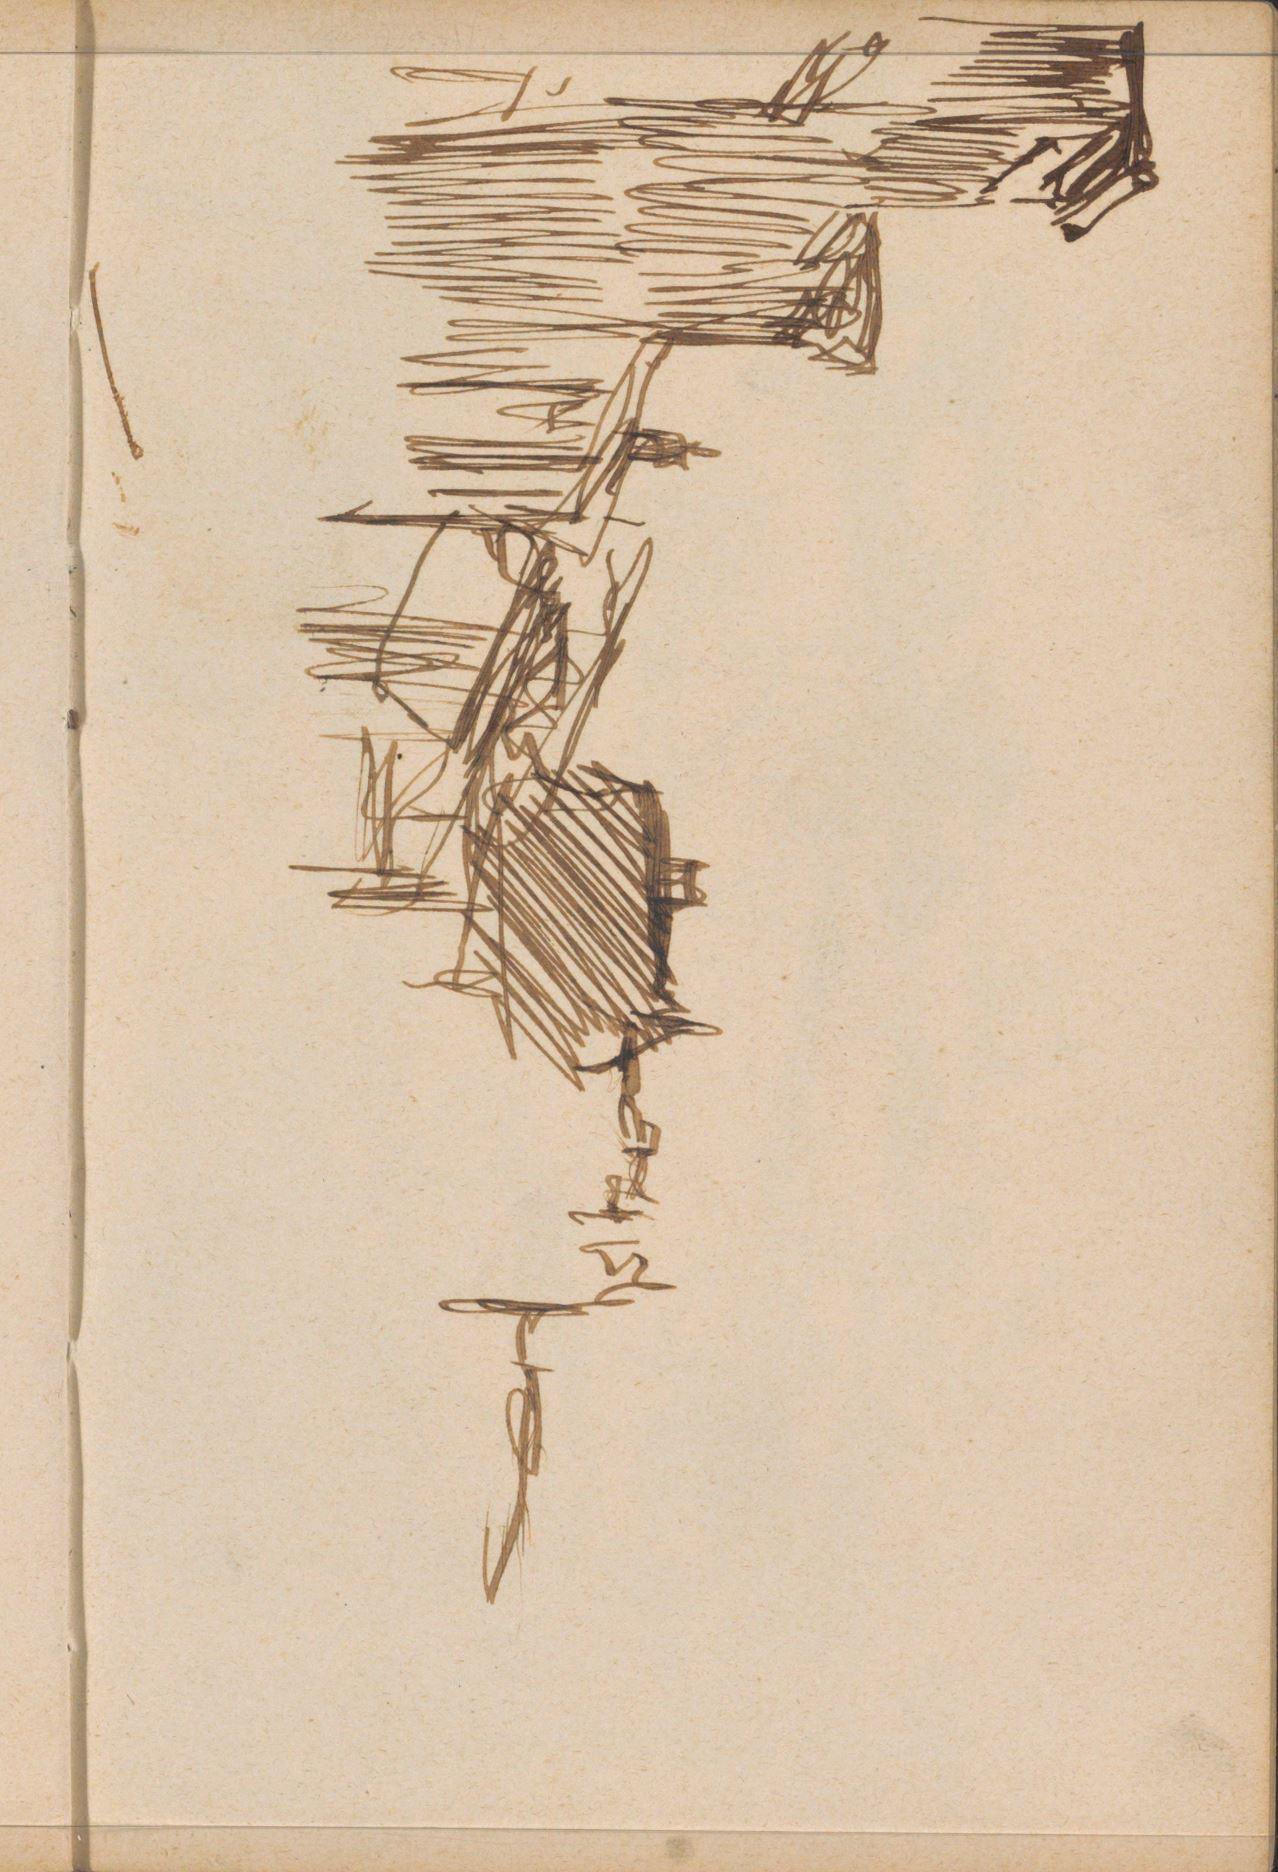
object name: sketchbook leaf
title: Stadsgezicht, mogelijk in Pittsburgh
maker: george hendrik breitner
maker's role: draughtsman, painter, print maker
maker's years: 1857-1923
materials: ink, paper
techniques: pen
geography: pittsburgh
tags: city-view, and landscape with man-made constructions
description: Stadsgezicht, mogelijk in Pittsburgh. Pagina 40 uit een schetsboek met 45 bladen vervaardigd in Amsterdam en Pittsburgh.